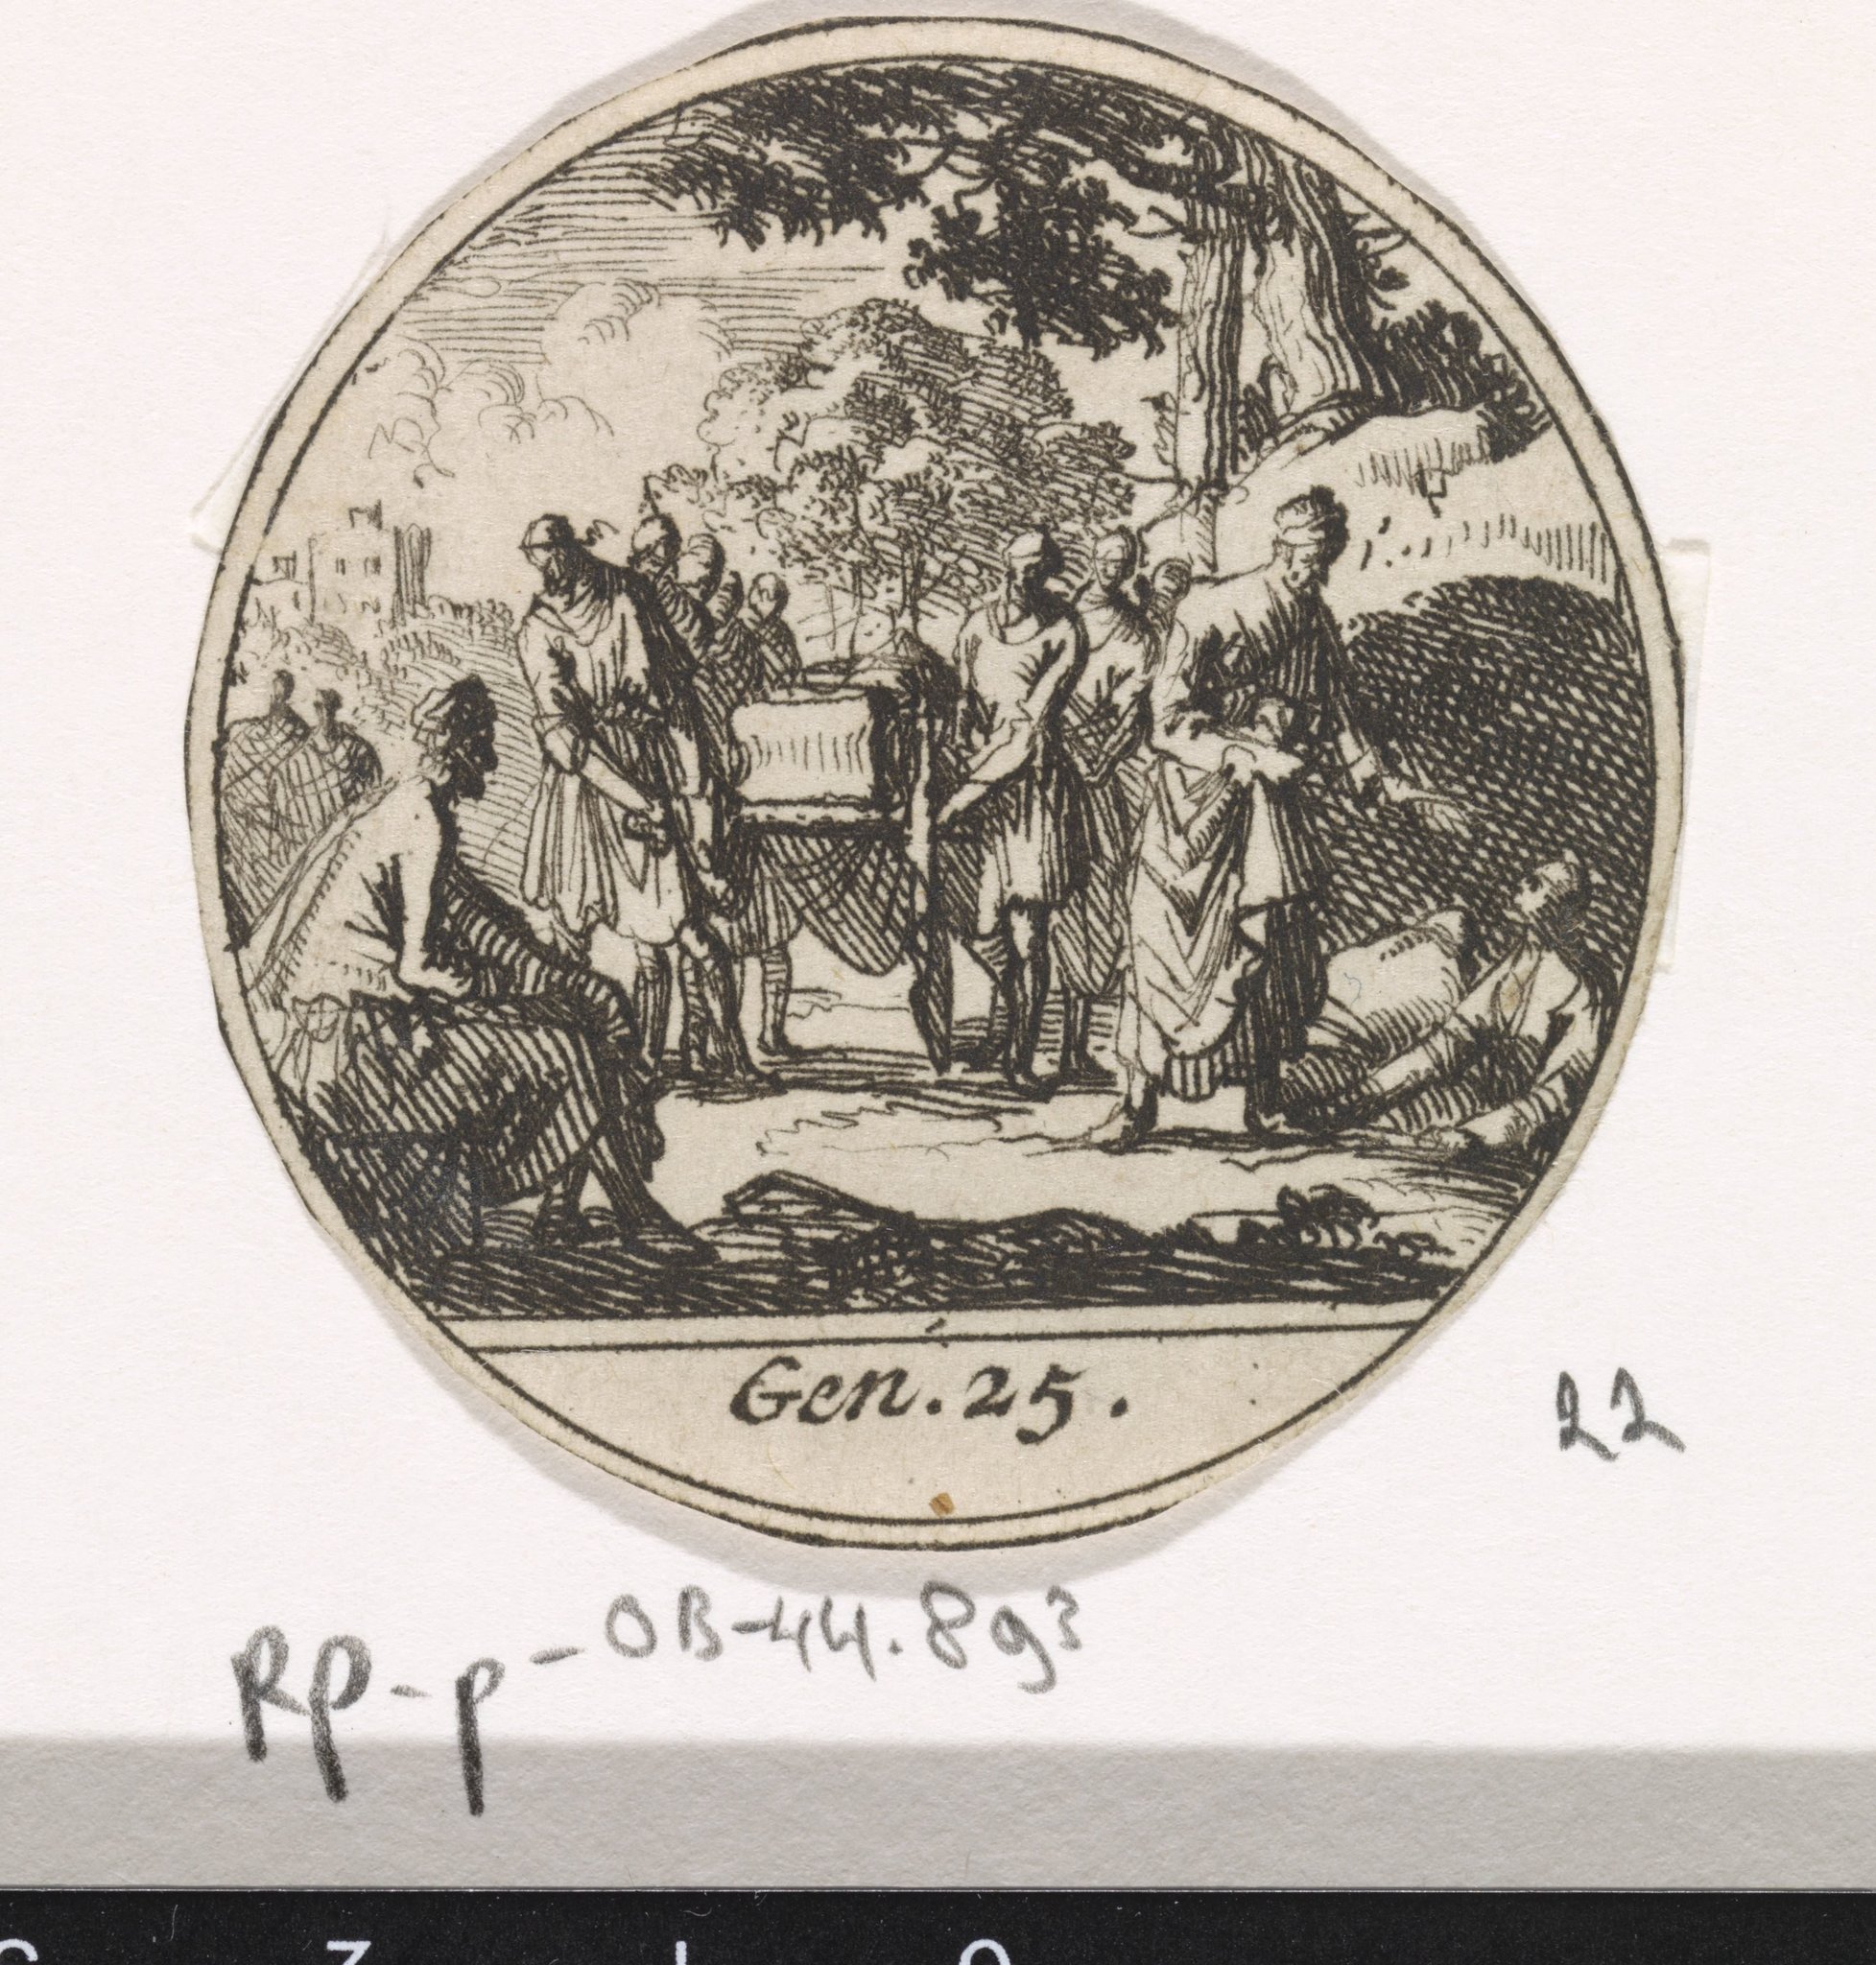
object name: book illustration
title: Begrafenis van Abraham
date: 1700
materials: paper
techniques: etching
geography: amsterdam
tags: abraham is buried by isaac and ishmael in the cave of machpelah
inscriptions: collector's mark: Lugt 240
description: Boekillustratie voor Willem Goeree. Mosaize historie der Hebreeuwse kerke. Amsterdam: Willem & David Goeree, 1700.